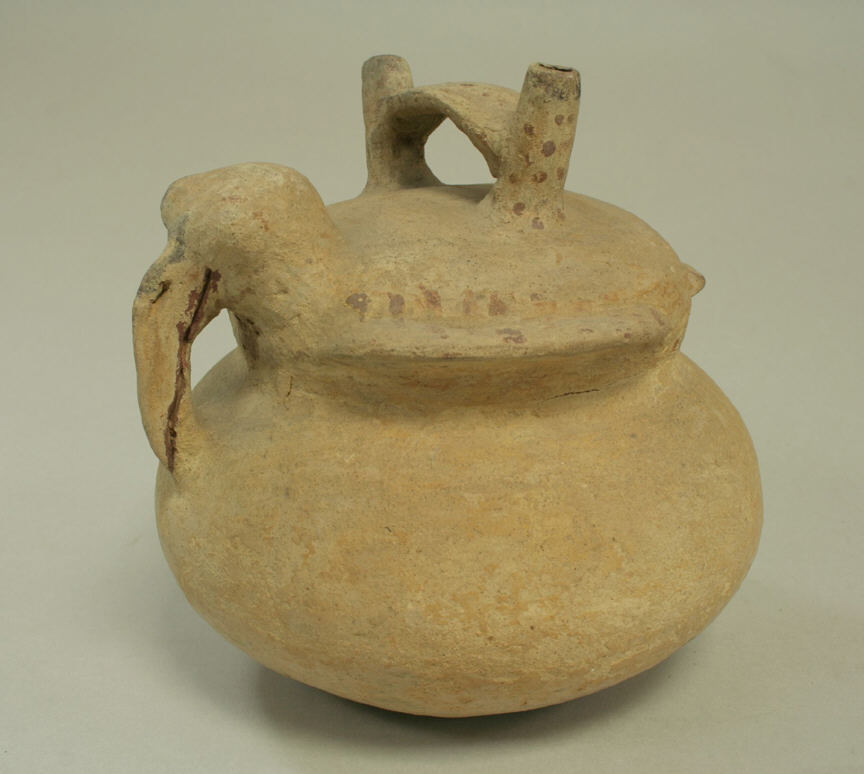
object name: bottle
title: Double Spout Bottle, Bird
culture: topará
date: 700-301 BCE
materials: ceramic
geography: peru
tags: birds